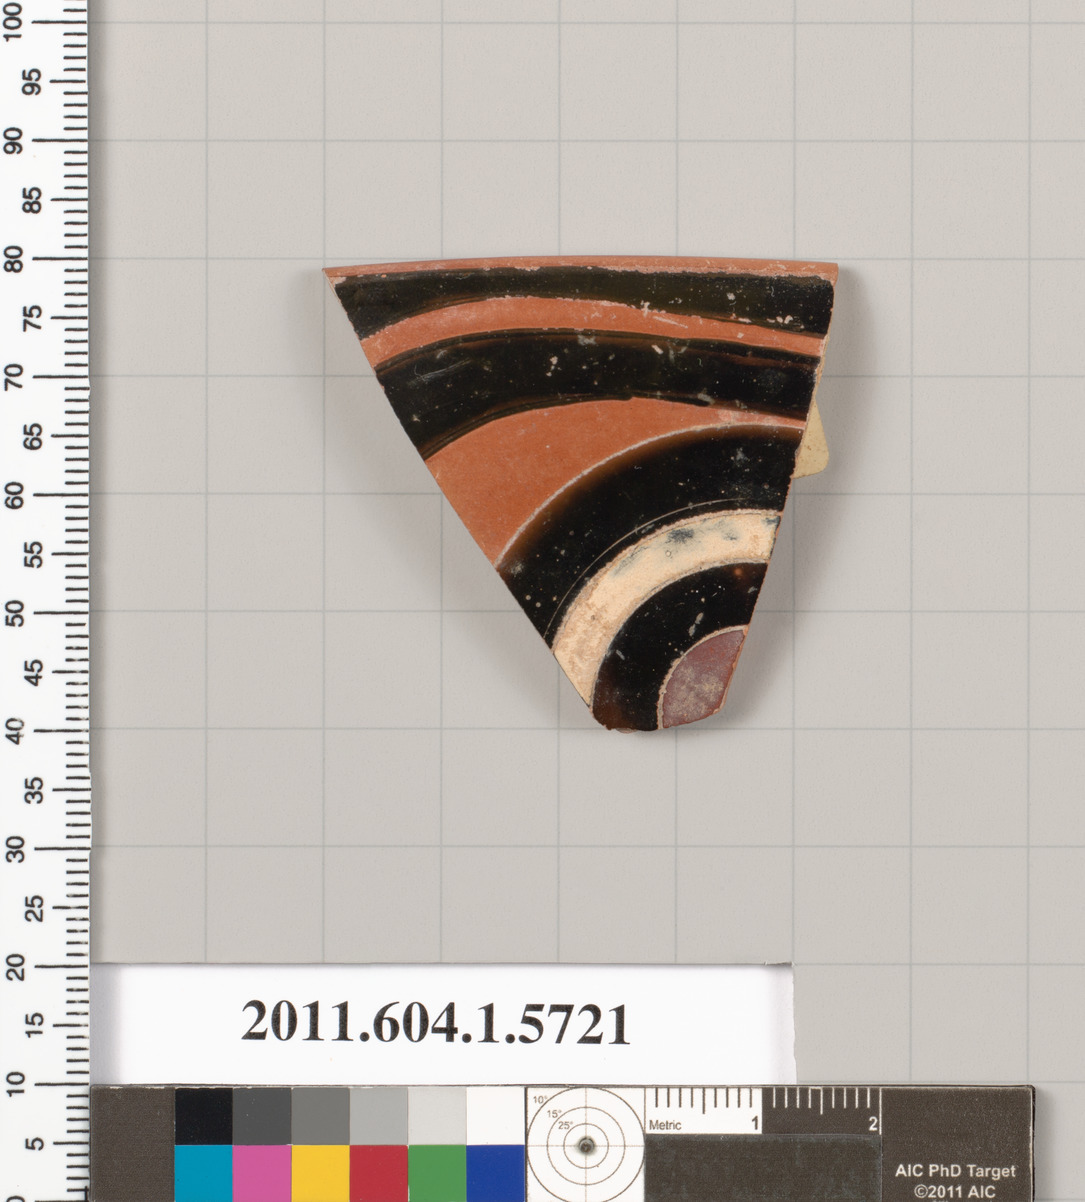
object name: kylix fragment, eye cup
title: Terracotta rim fragment of a kylix: eye-cup (drinking cup)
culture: greek, attic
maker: oltos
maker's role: artist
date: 525-515 BCE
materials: terracotta